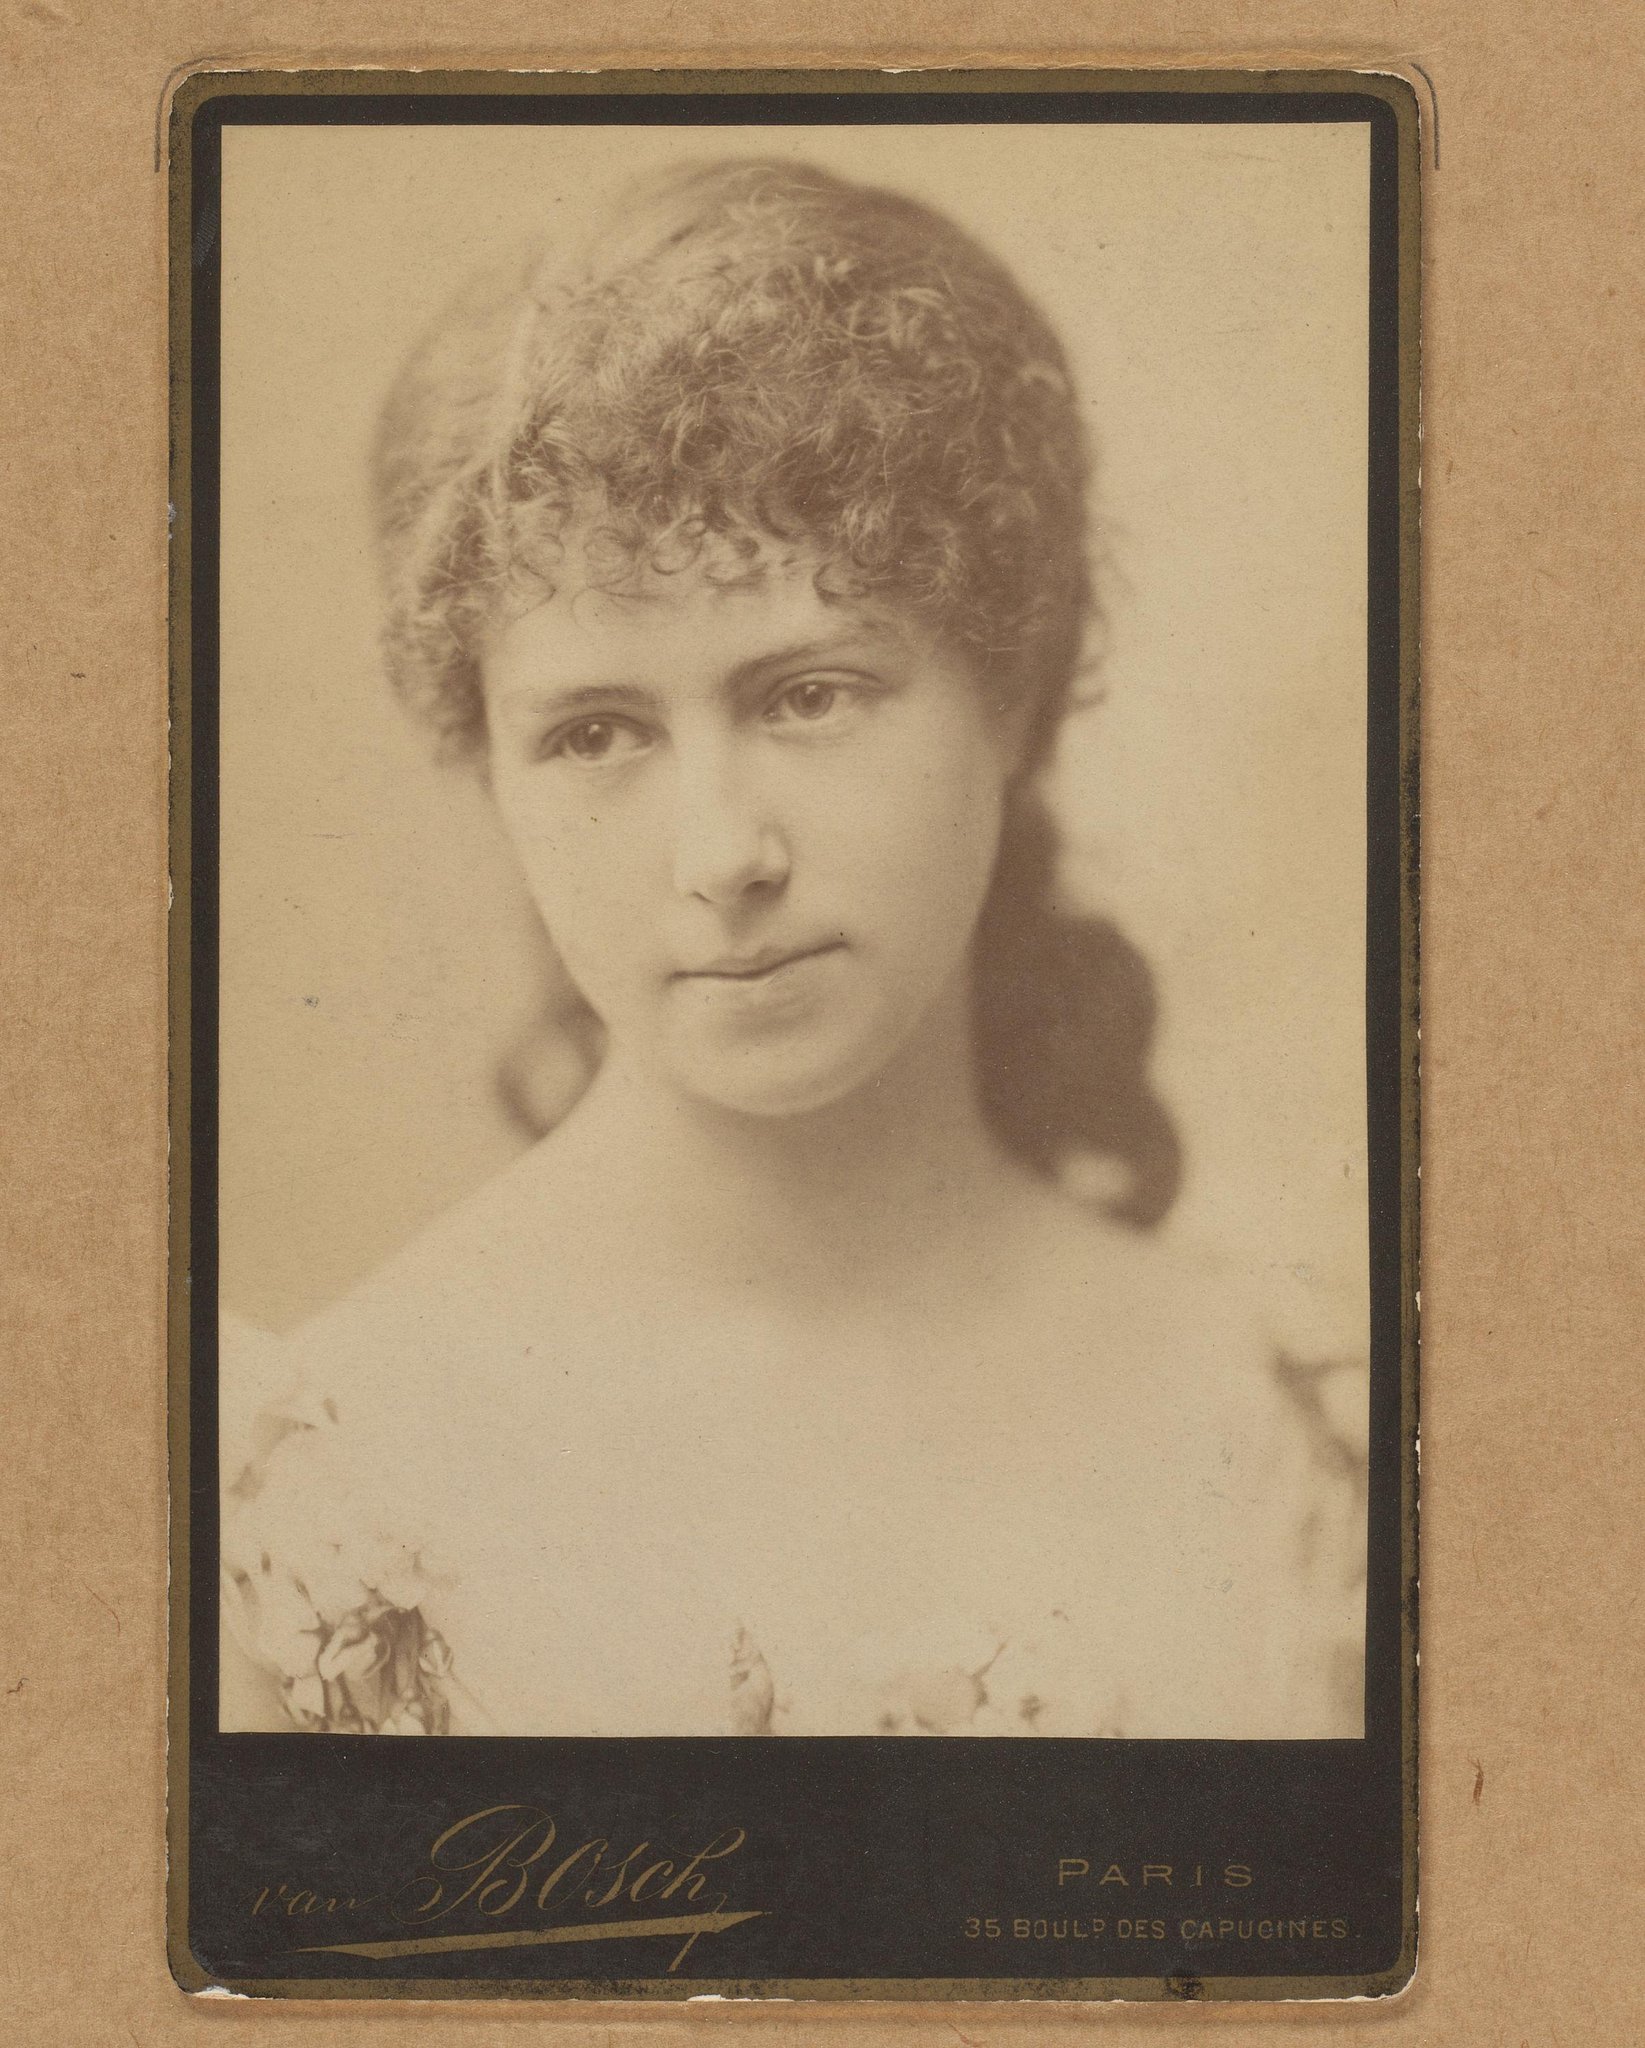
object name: cabinet photograph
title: Portret van een onbekende vrouw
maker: otto van bosch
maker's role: fotograaf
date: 1875-1906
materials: cardboard, paper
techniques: albumen print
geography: paris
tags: historical persons - bb - woman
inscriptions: inscription: ‘33.33/ Geschenk F.G. Waller/ "chatelain"’, address: ‘van Bosch/ PARIS/ 35 BOULD DES CAPUCINES.’, inscription: ‘Van Zandt’